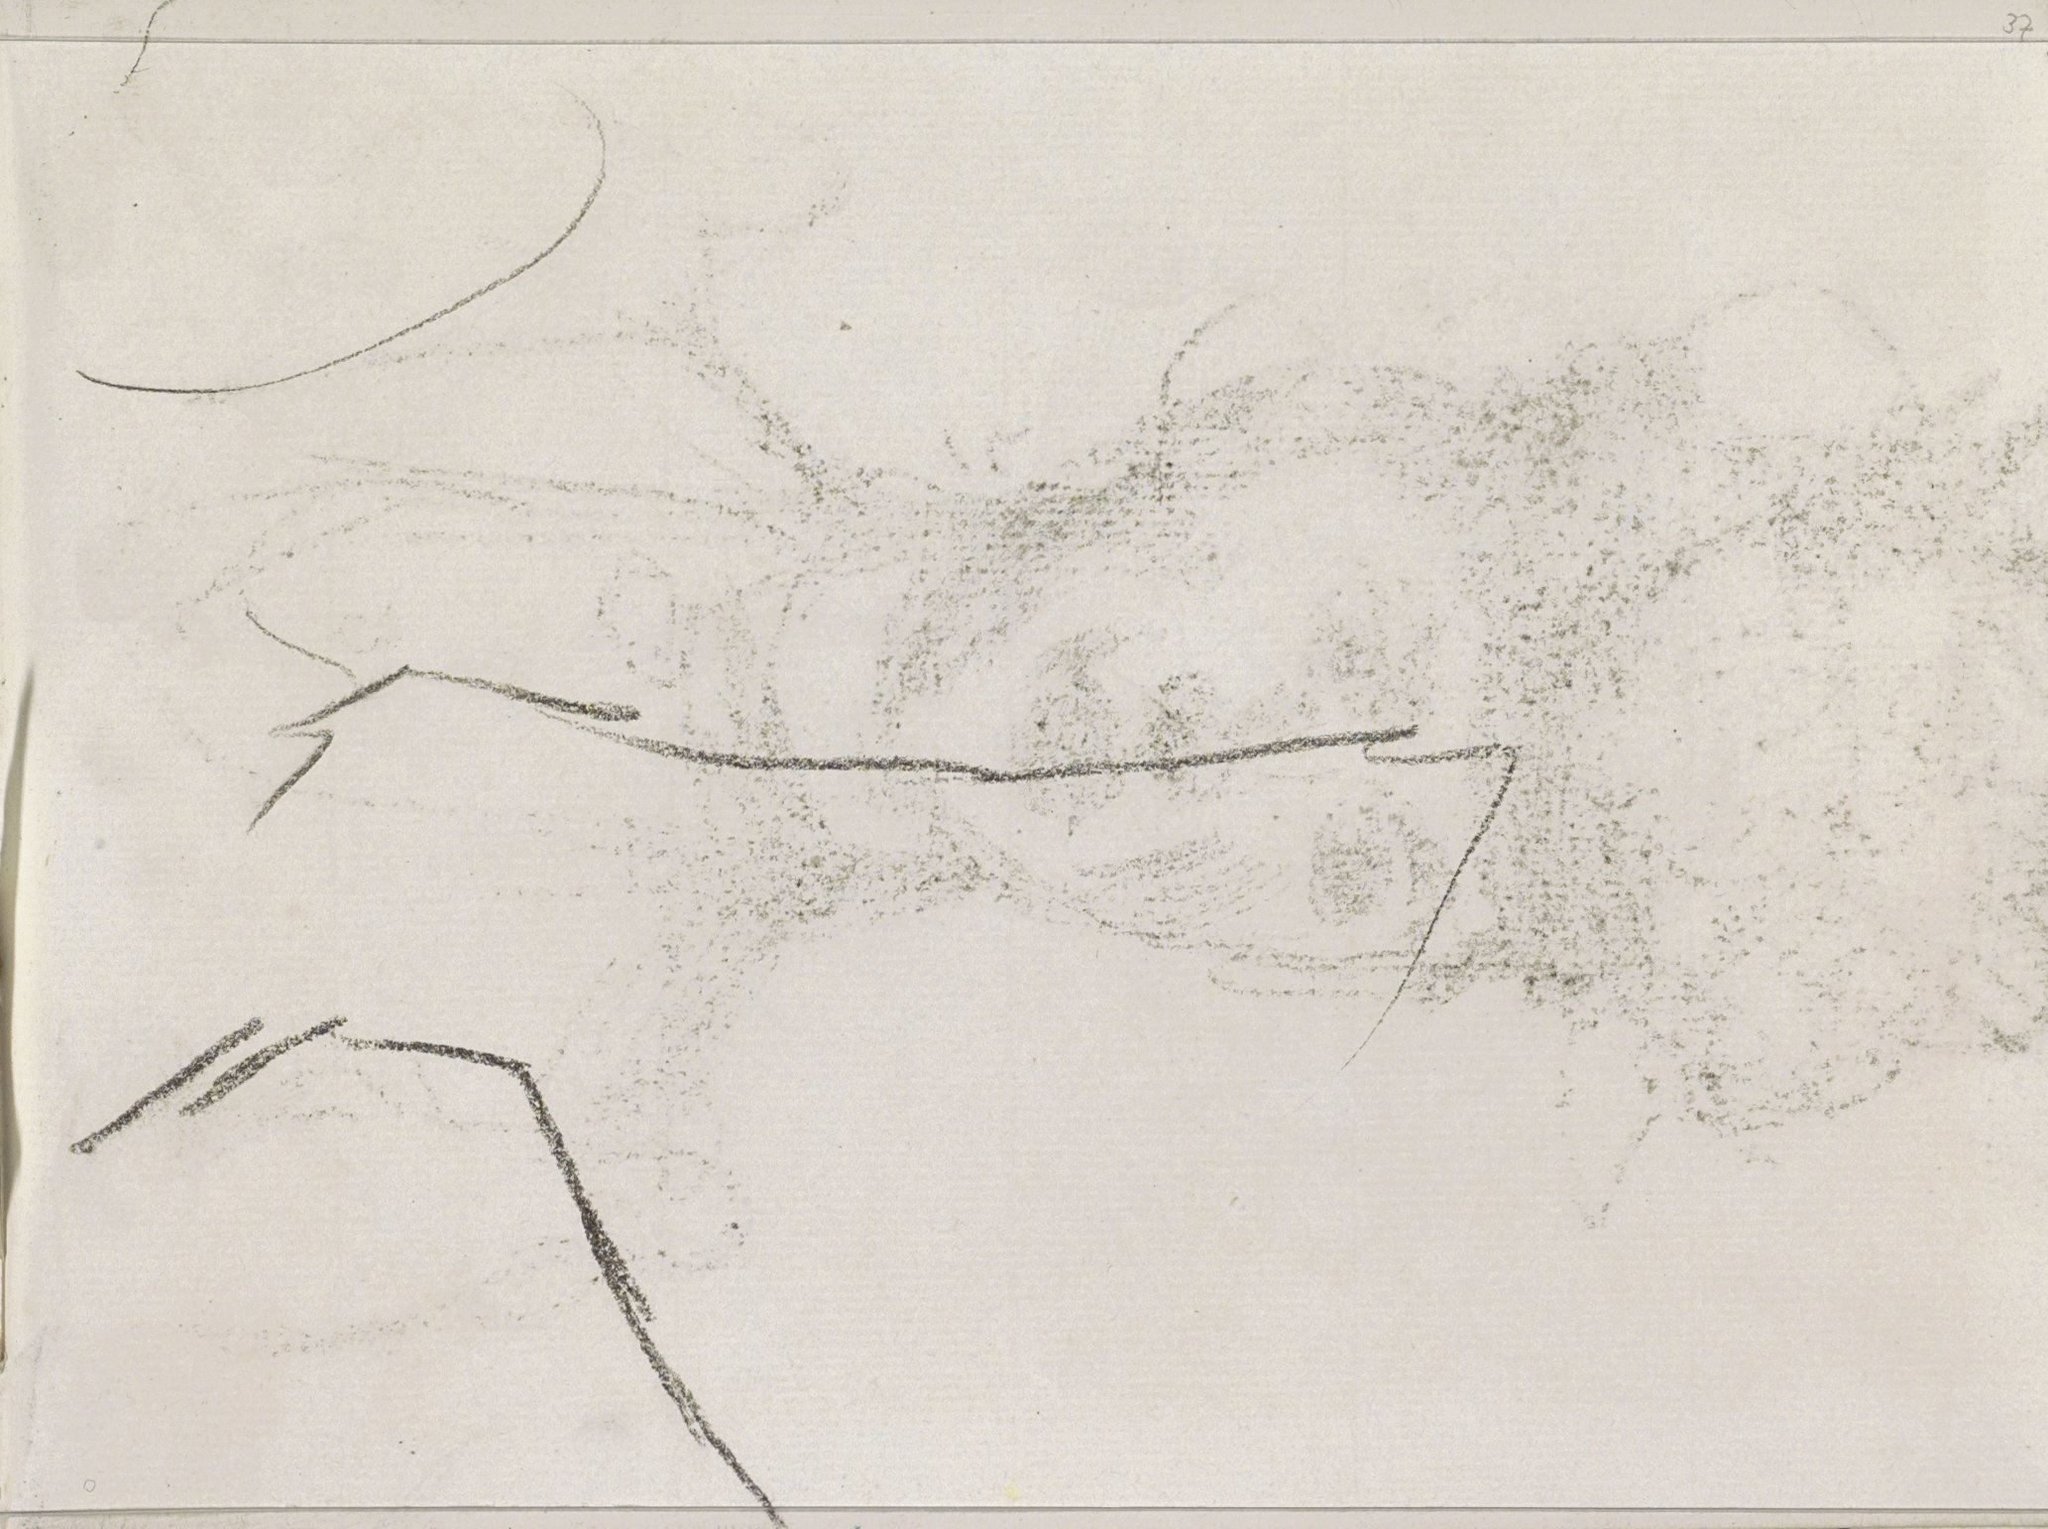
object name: sketchbook leaf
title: Studie en een abklatsch van een krijttekening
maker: isaac israels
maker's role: draughtsman, painter, print maker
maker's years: 1865-1934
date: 1875-1934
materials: chalk, paper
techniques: printmaking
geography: the hague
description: De originele tekening van een vrouwenhoofd met hoed is niet meer in het schetsboek aanwezig. Pagina 37 uit schetsboek XLI met 38 pagina's.